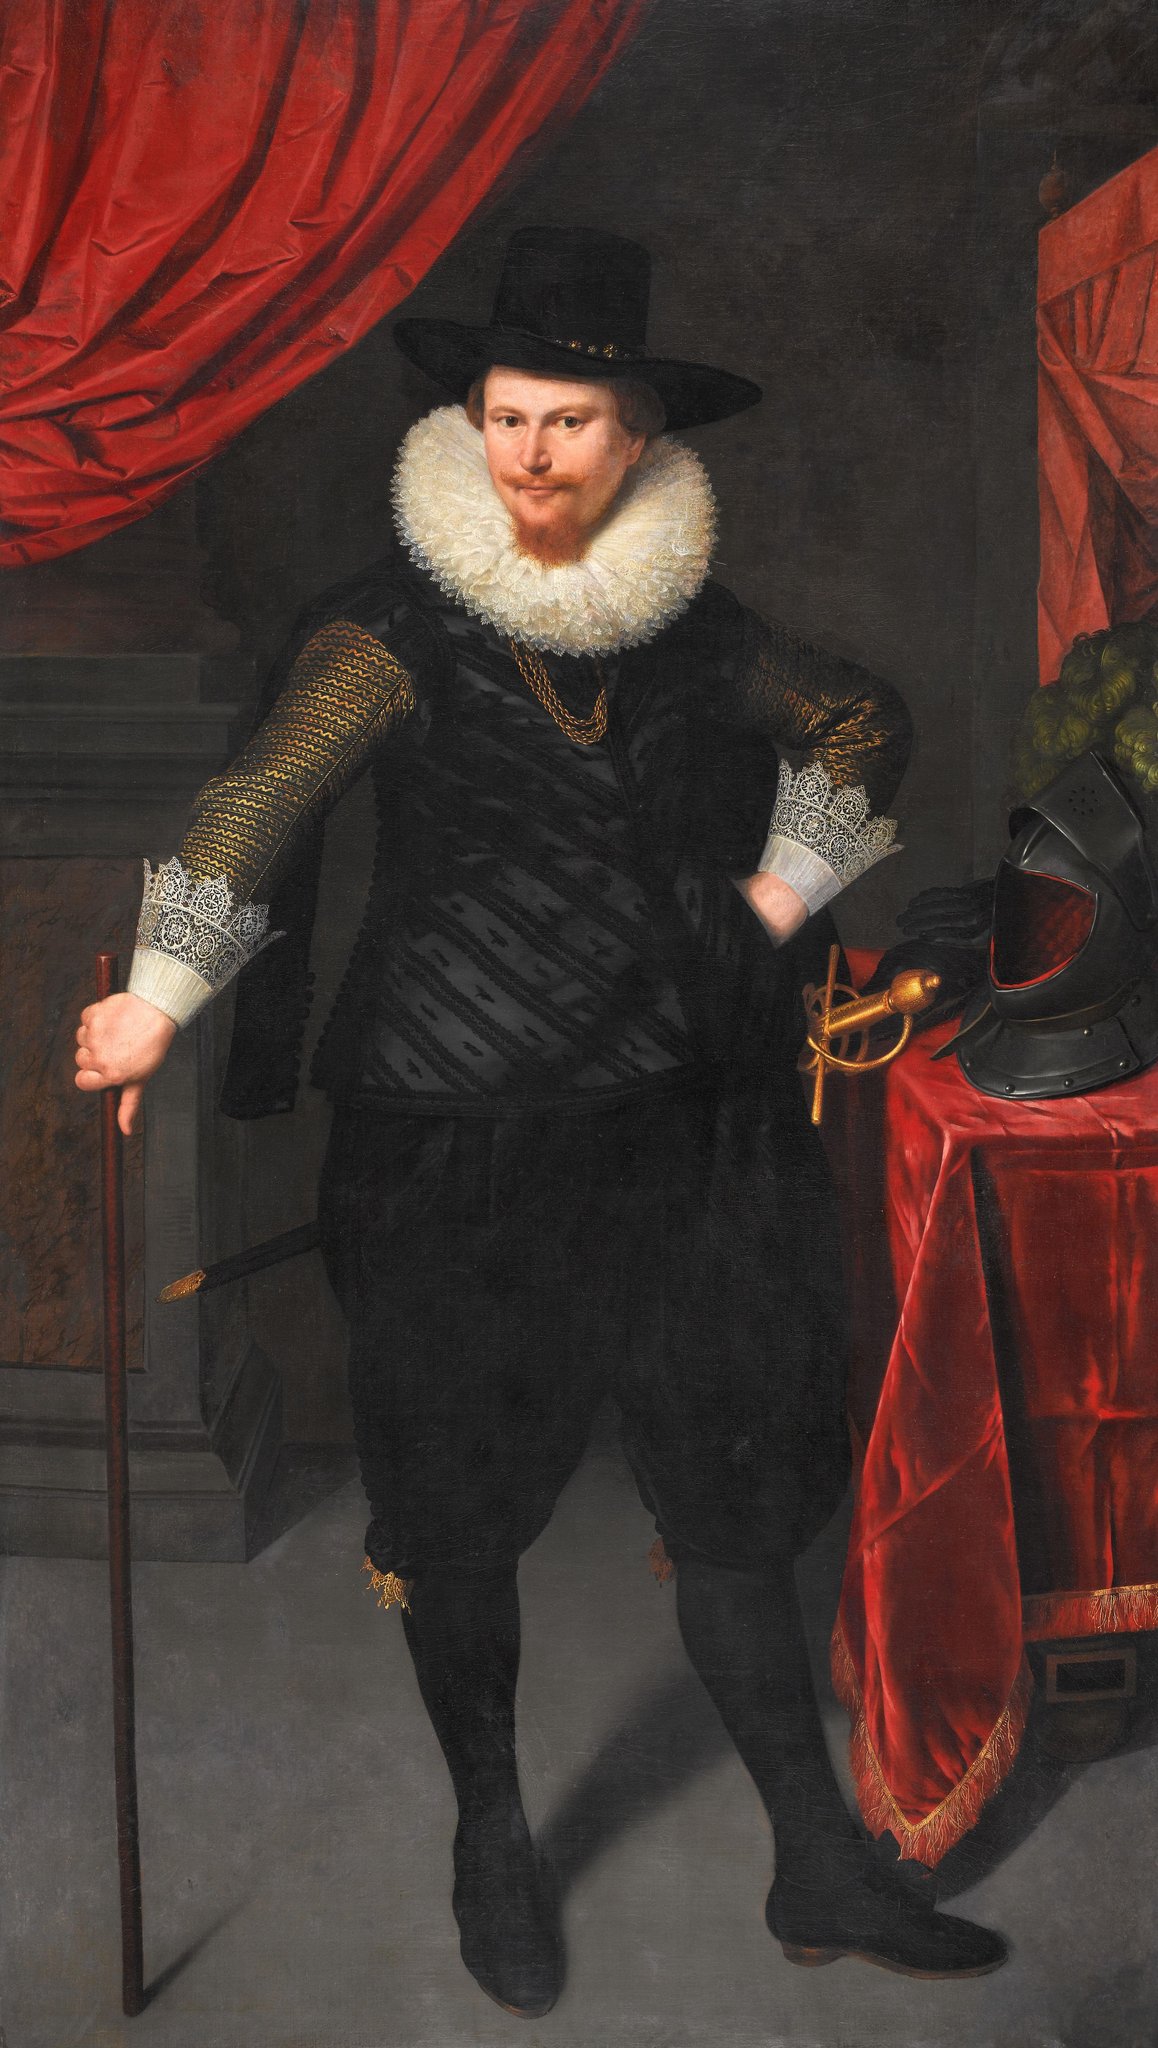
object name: painting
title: Portrait of Laurens Reael (1583-1637)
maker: cornelis van der voort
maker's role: draughtsman, painter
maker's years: 1576-1624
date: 1620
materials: canvas, oil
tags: laurens reael, colonial governor, historical persons (+ full length portrait), dutch east indies, the, amsterdam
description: In the early days of the Dutch East India Company (VOC), key administrators debated the deployment of enslaved people. Governor General Laurens Reael, for example, did not see slavery as a solution to the labour shortage. This was not based on moral grounds for, according to him, they would always try to flee, ‘because it is difficult to forget the pleasures of the country where one was born and raised.’